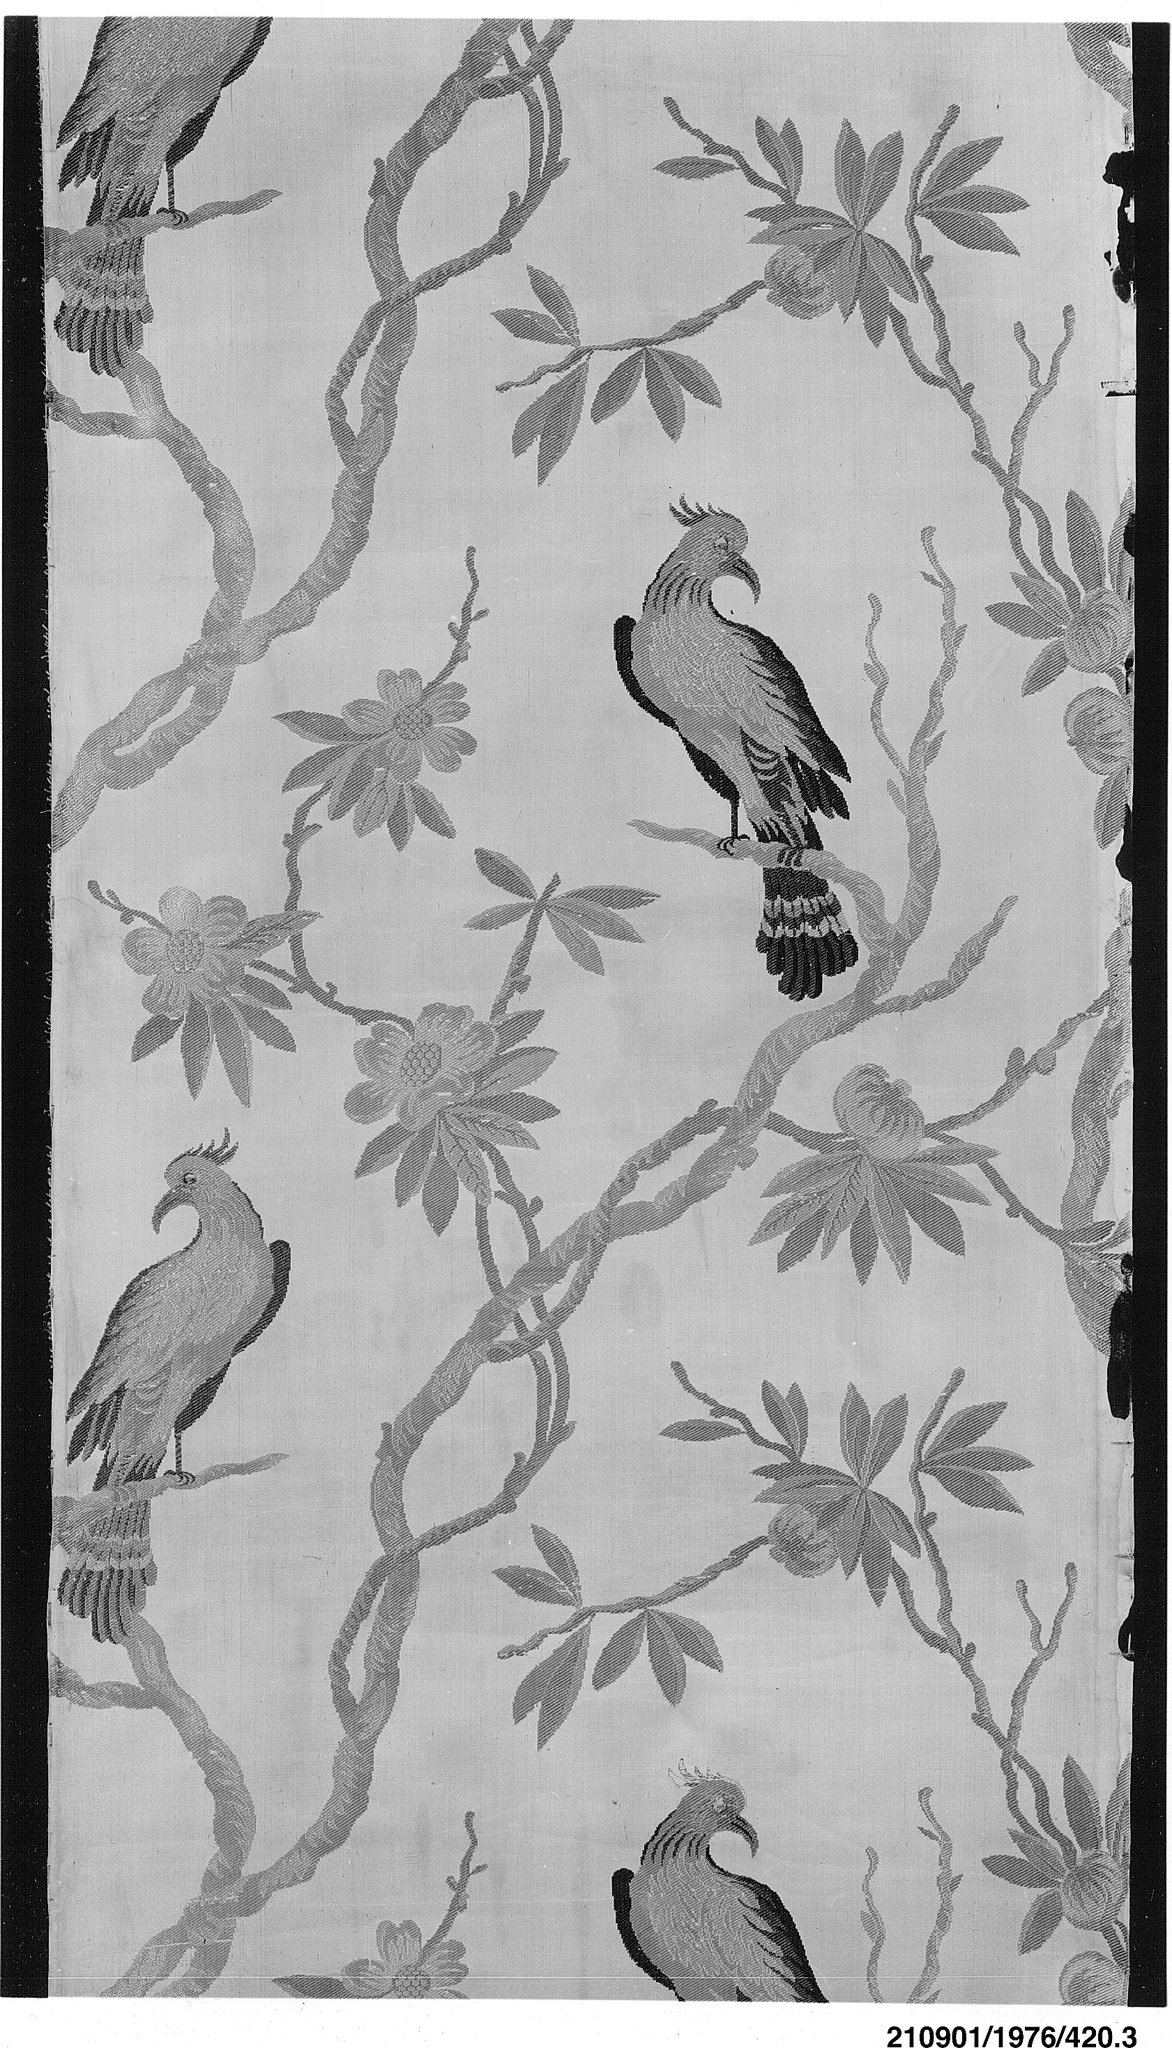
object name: panel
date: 1701-1800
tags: birds,flowers,leaves